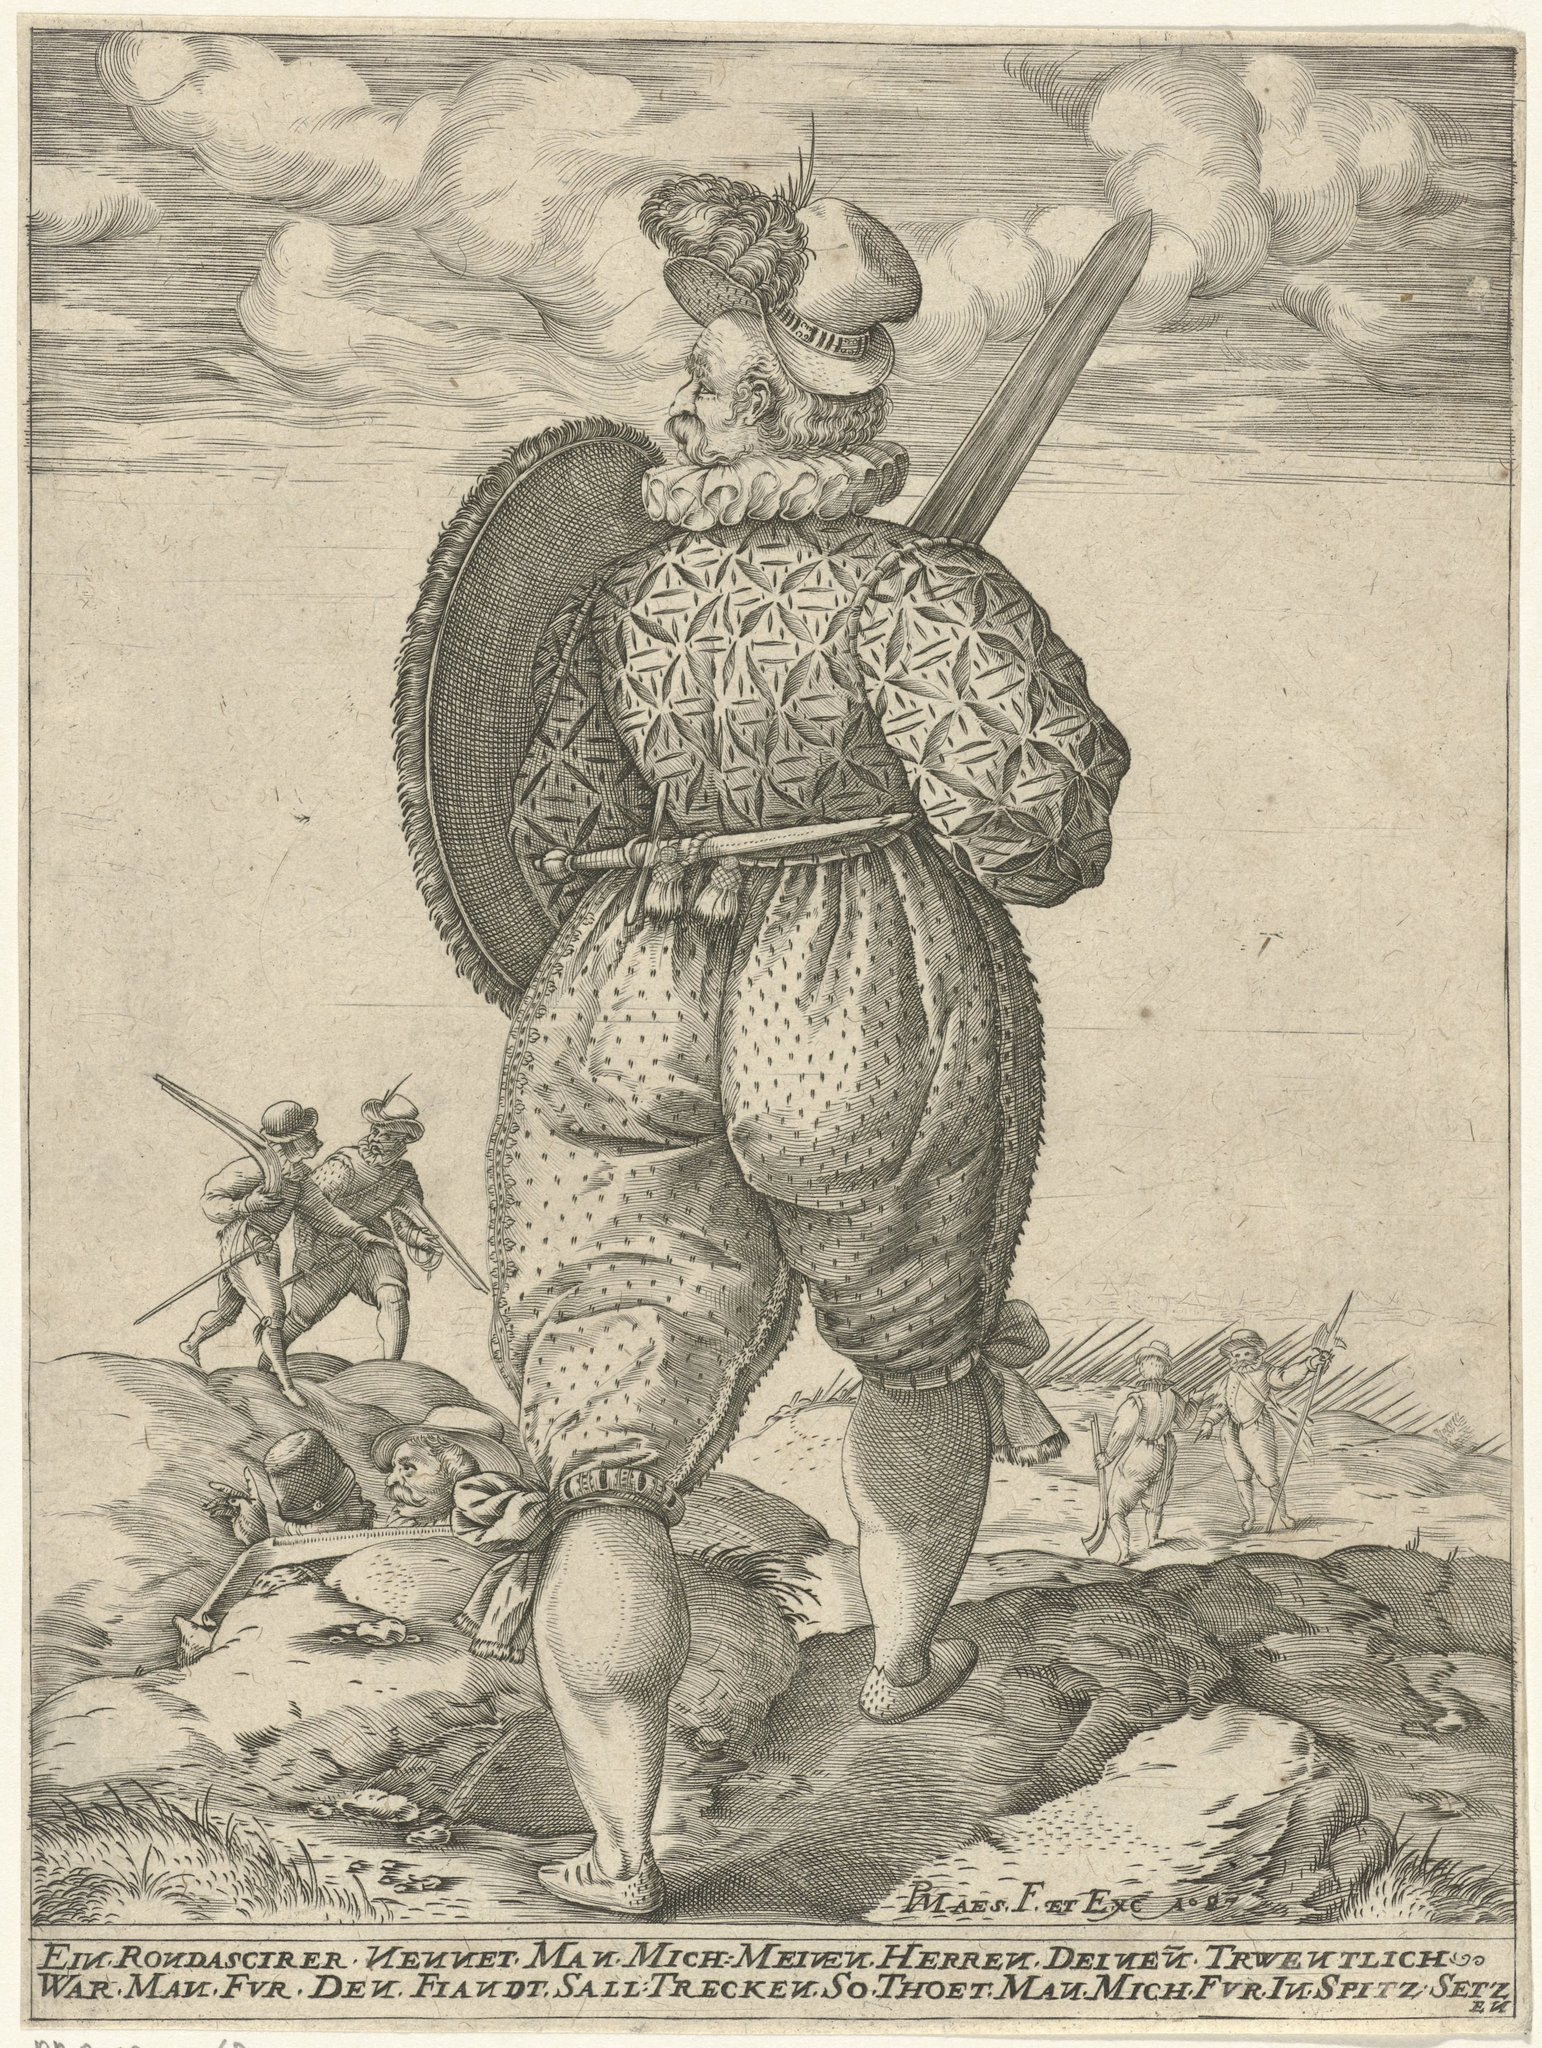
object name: print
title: Soldaat met zwaard en schild, van achteren gezien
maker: pieter maes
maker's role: print maker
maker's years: 1560-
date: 1587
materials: paper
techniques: engraving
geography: low countries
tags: the soldier; the soldier's life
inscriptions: collector's mark: Lugt 2228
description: Soldaat op de rug gezien, met schild en zwaard, in een landschap waarin op de achtergrond nog meer soldaten.